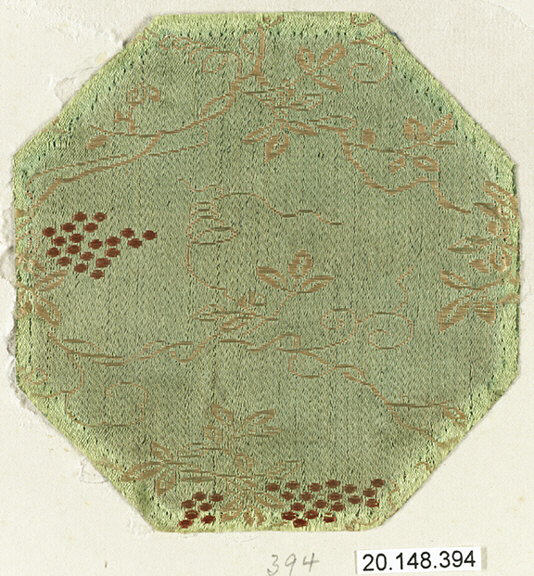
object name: piece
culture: japanese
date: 1601-1700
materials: silk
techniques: compound weave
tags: leaves